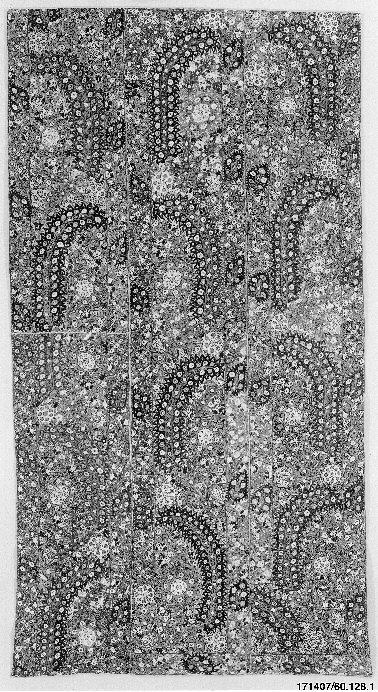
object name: hanging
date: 1701-1800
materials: linen, silk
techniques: embroidery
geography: greece